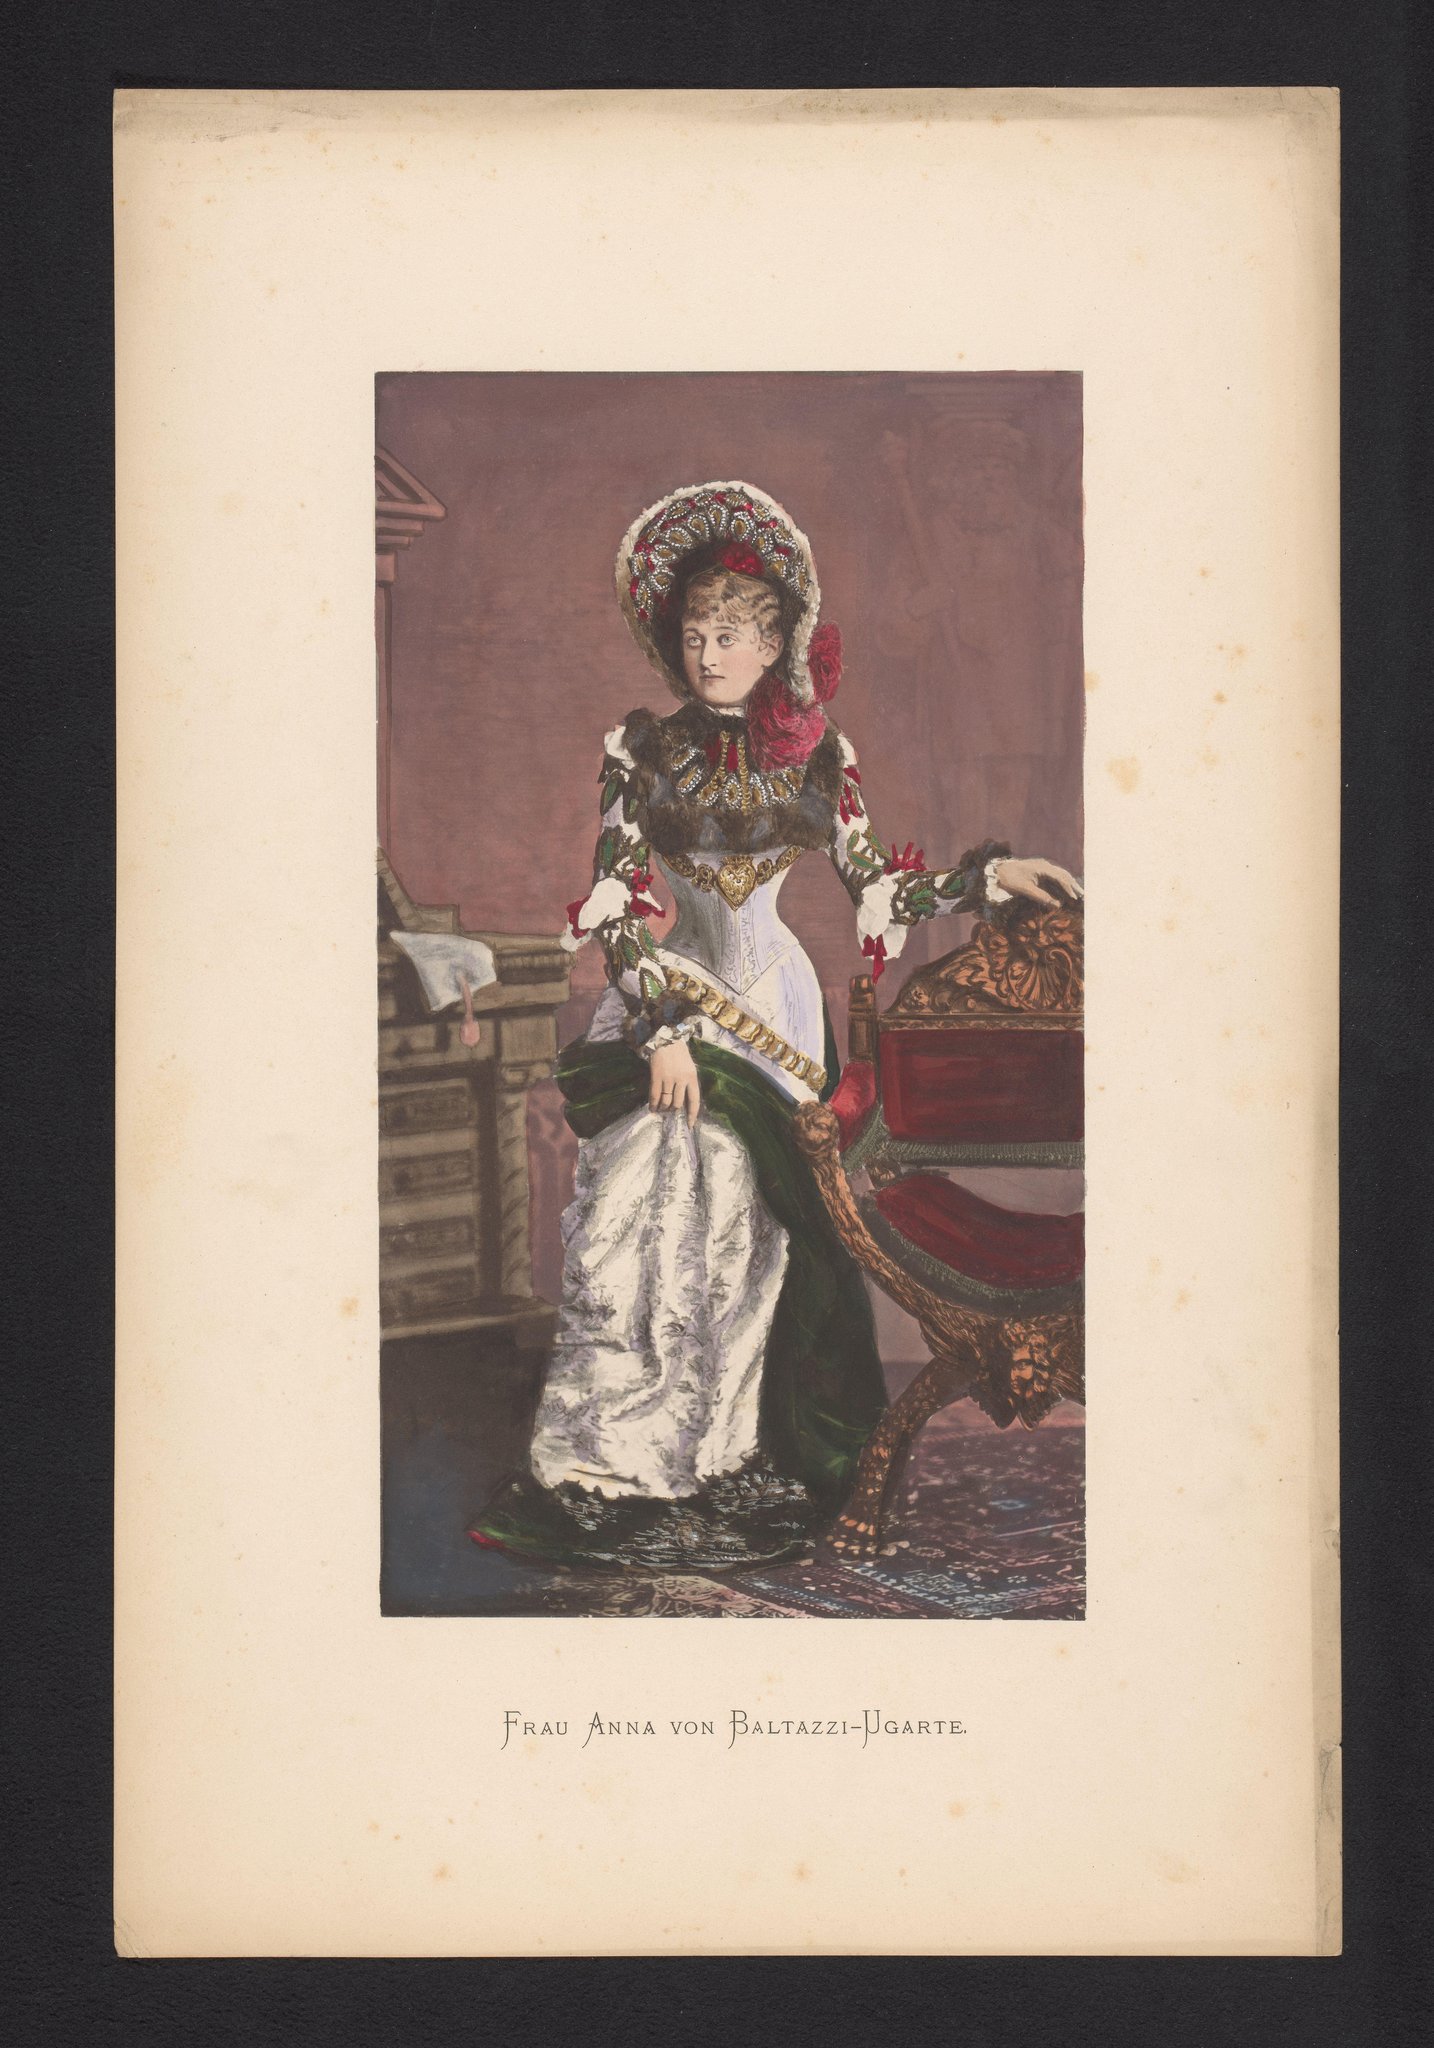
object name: photomechanical print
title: Portret van Anna Baltazzi-Ugarte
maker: Anonymous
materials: paper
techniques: photograph, hand coloring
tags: historical persons - bb - woman, aristocracy; 'aristocratia' (ripa)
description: Deze prent maakt deel uit van een omslag met 86 prenten op 78 bladen en 11 tekstbladen.